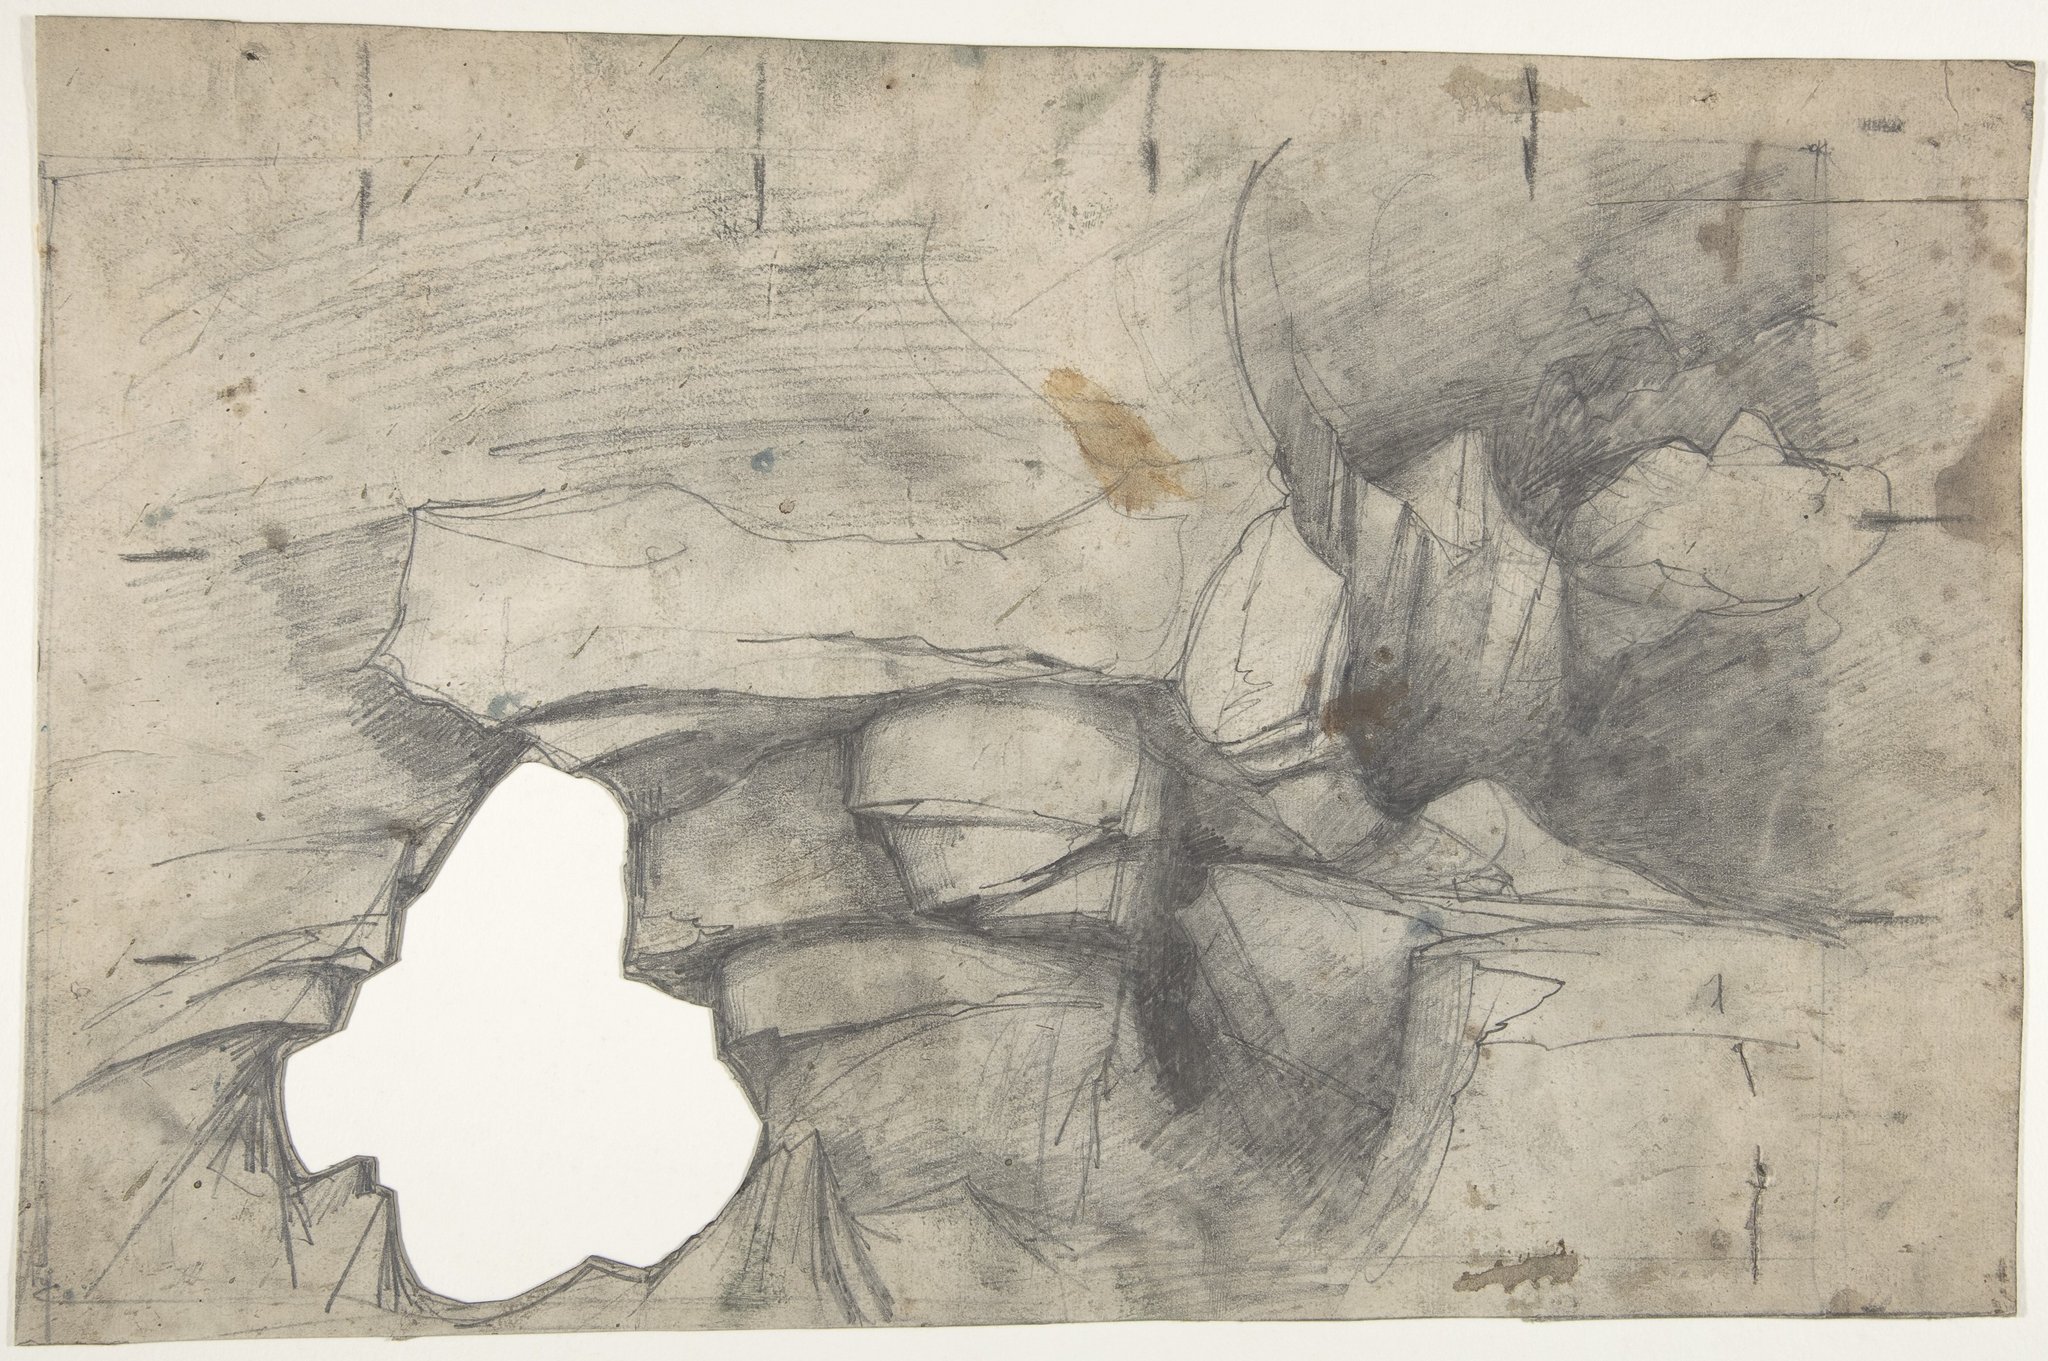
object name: drawing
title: Design for a Stage Set at the Opéra, Paris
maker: eugène cicéri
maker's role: artist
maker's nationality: french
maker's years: 1813-1890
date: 1830-1890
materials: graphite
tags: stage design